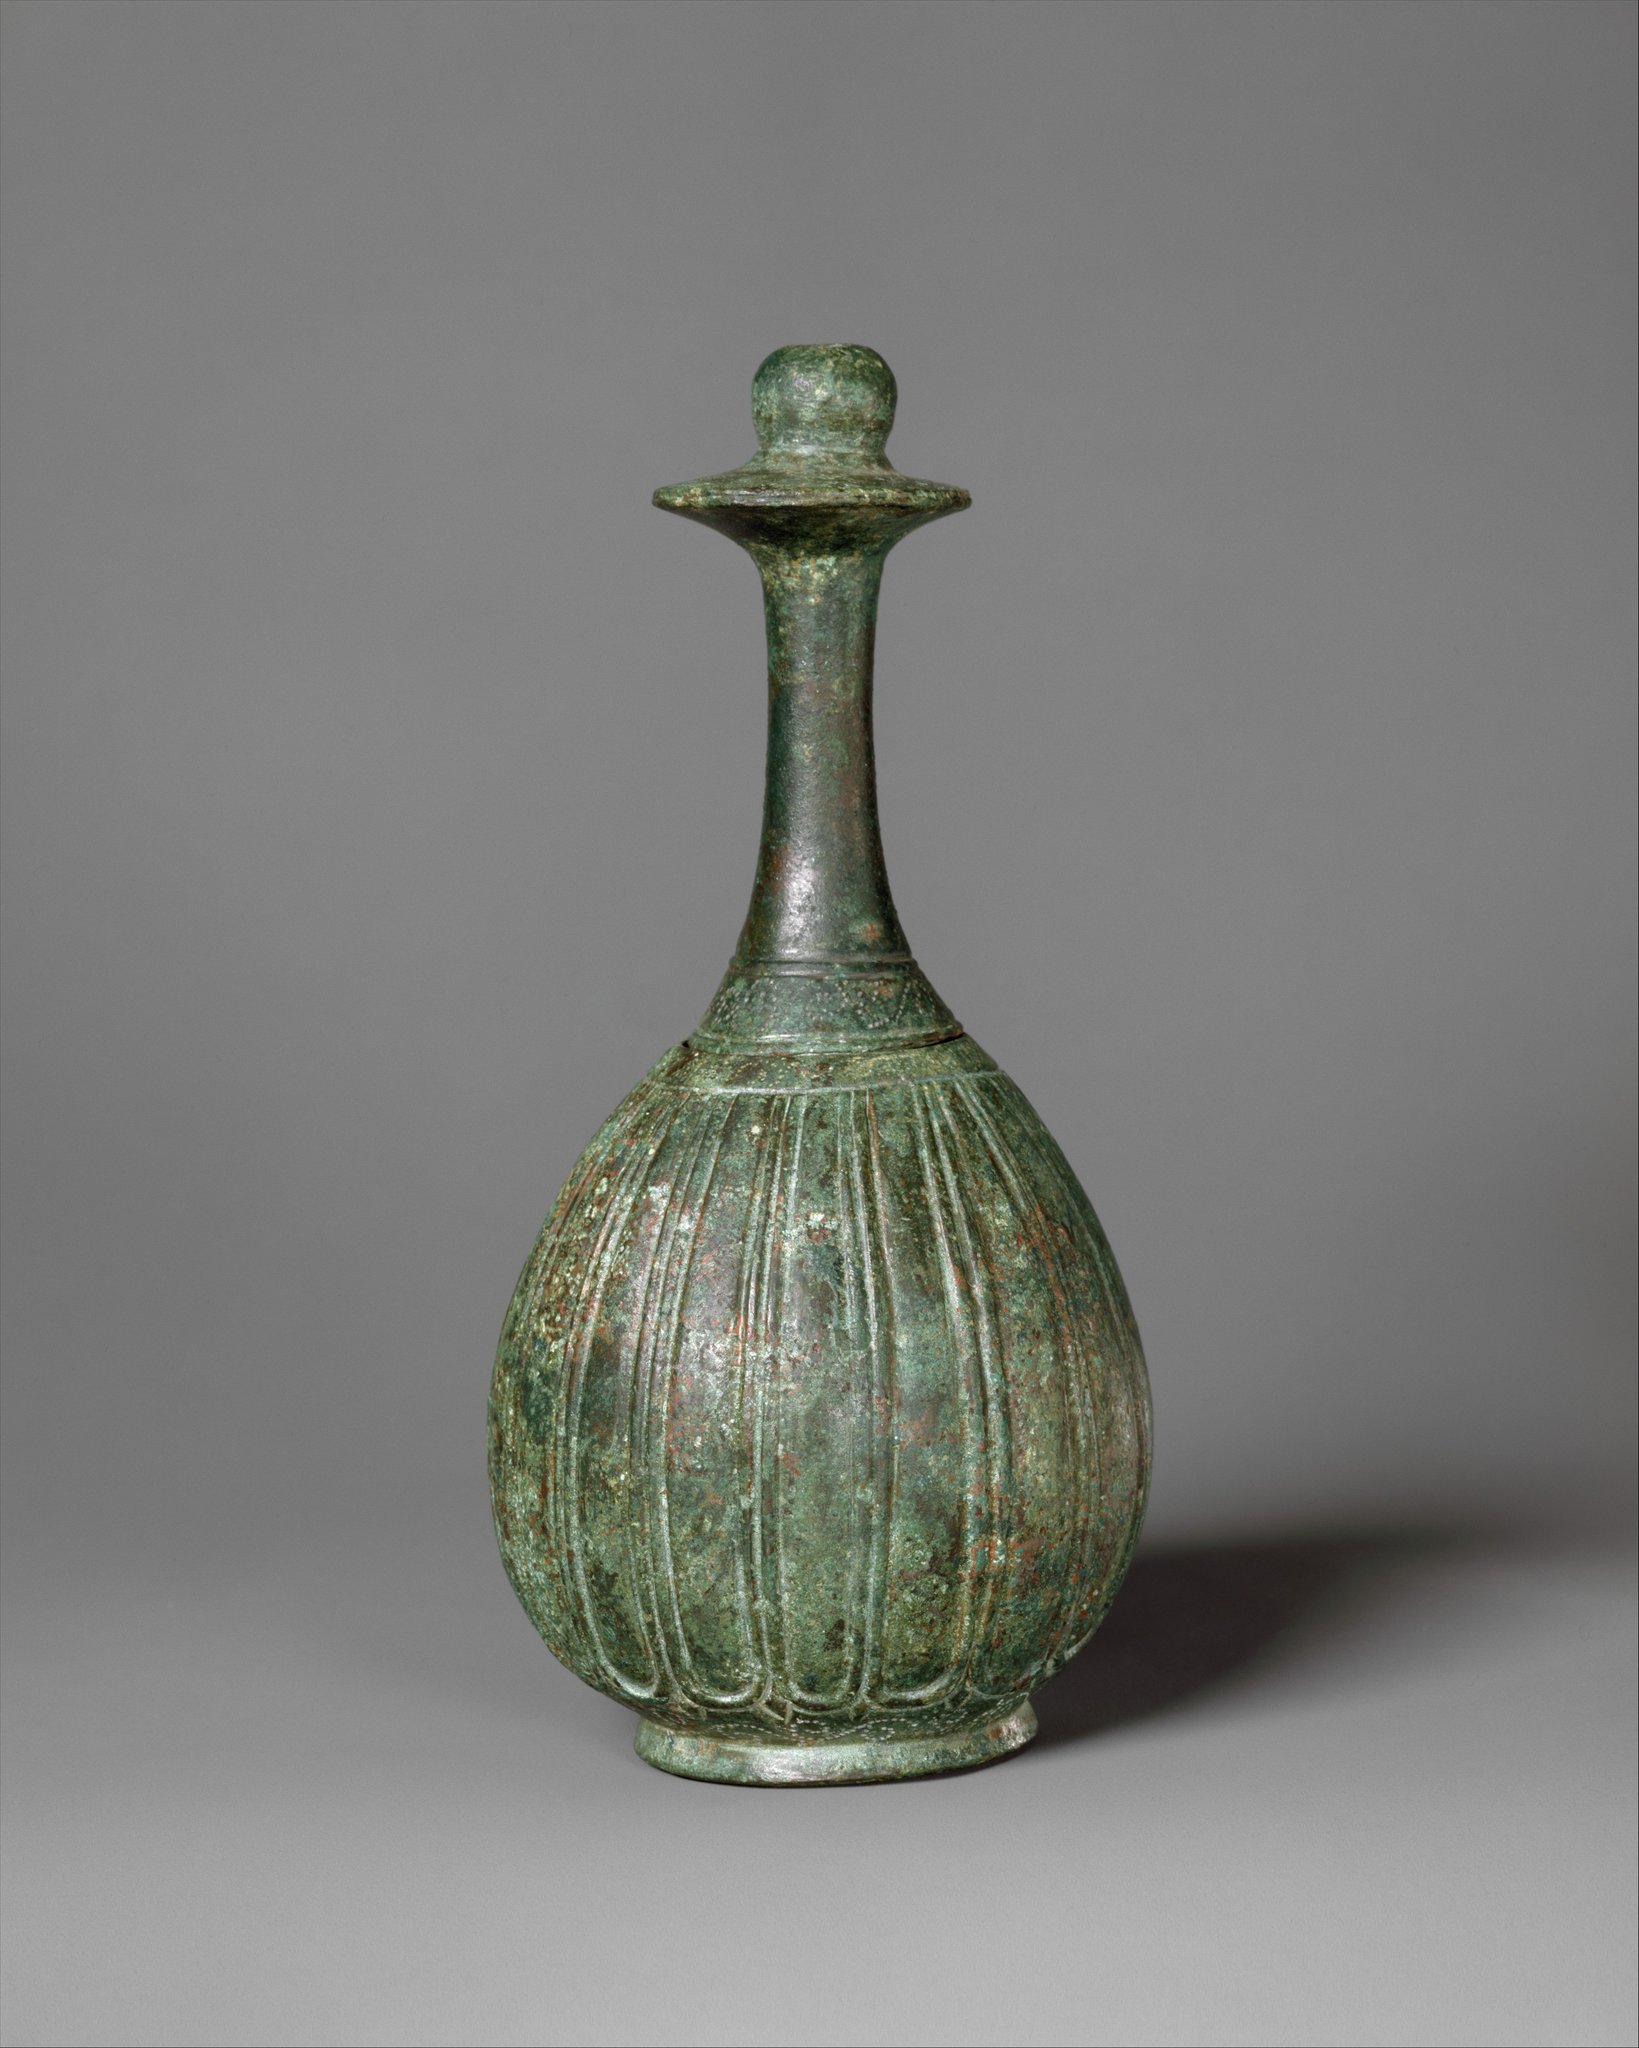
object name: perirrhanterion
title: Bronze perirrhanterion (sprinkler)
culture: greek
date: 350-301 BCE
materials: bronze